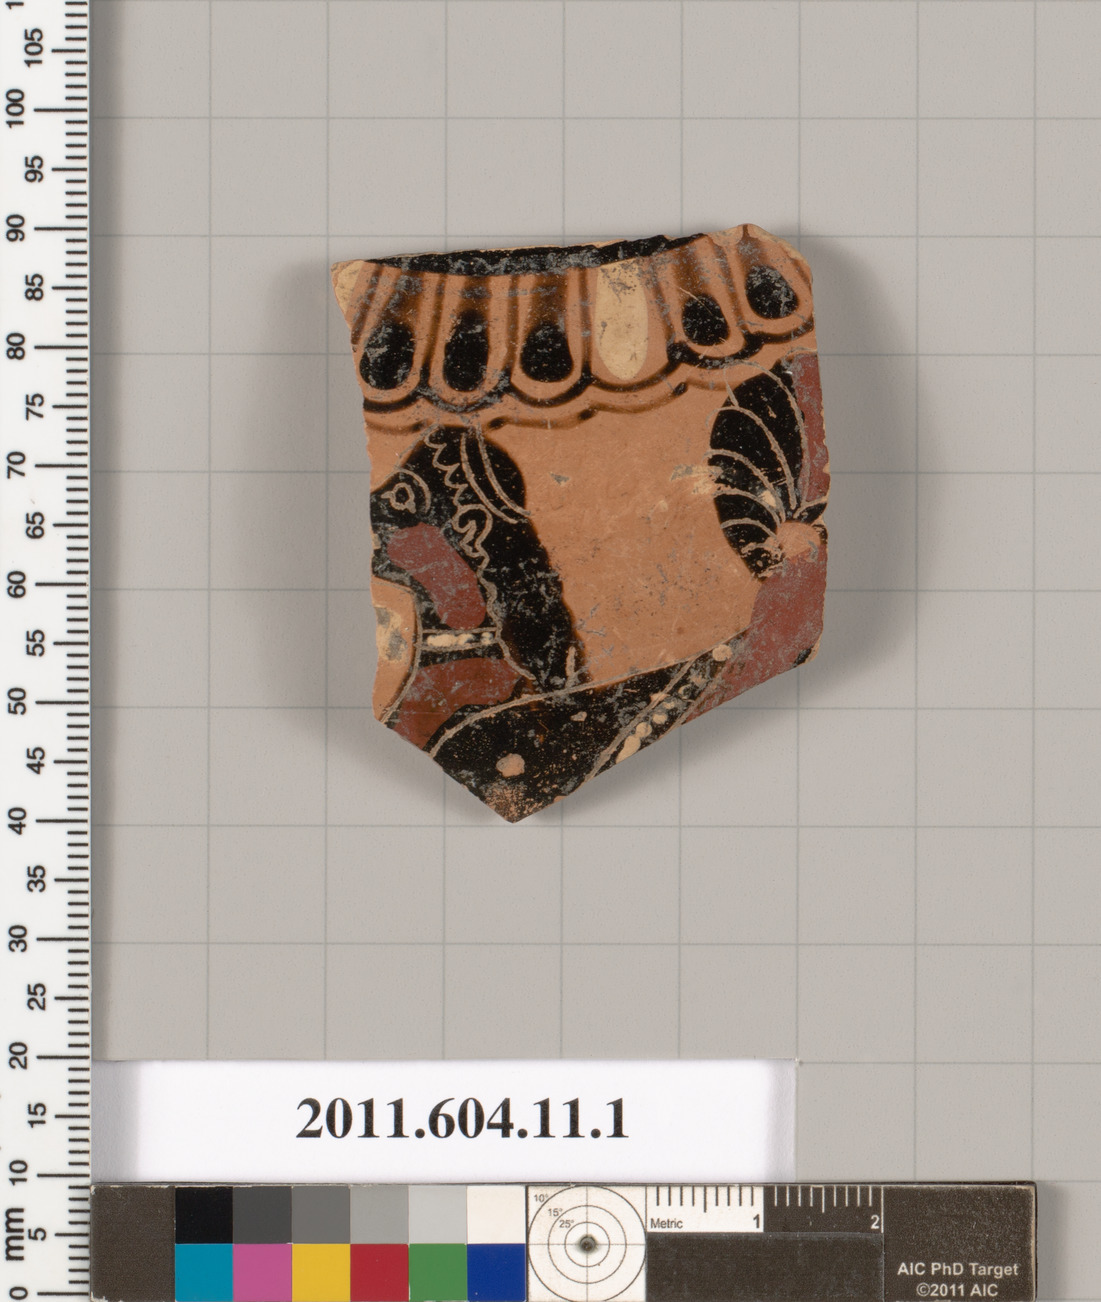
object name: neck amphora fragment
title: Terracotta fragment of a neck-amphora (jar)?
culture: greek, chalcidian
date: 540 BCE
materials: terracotta